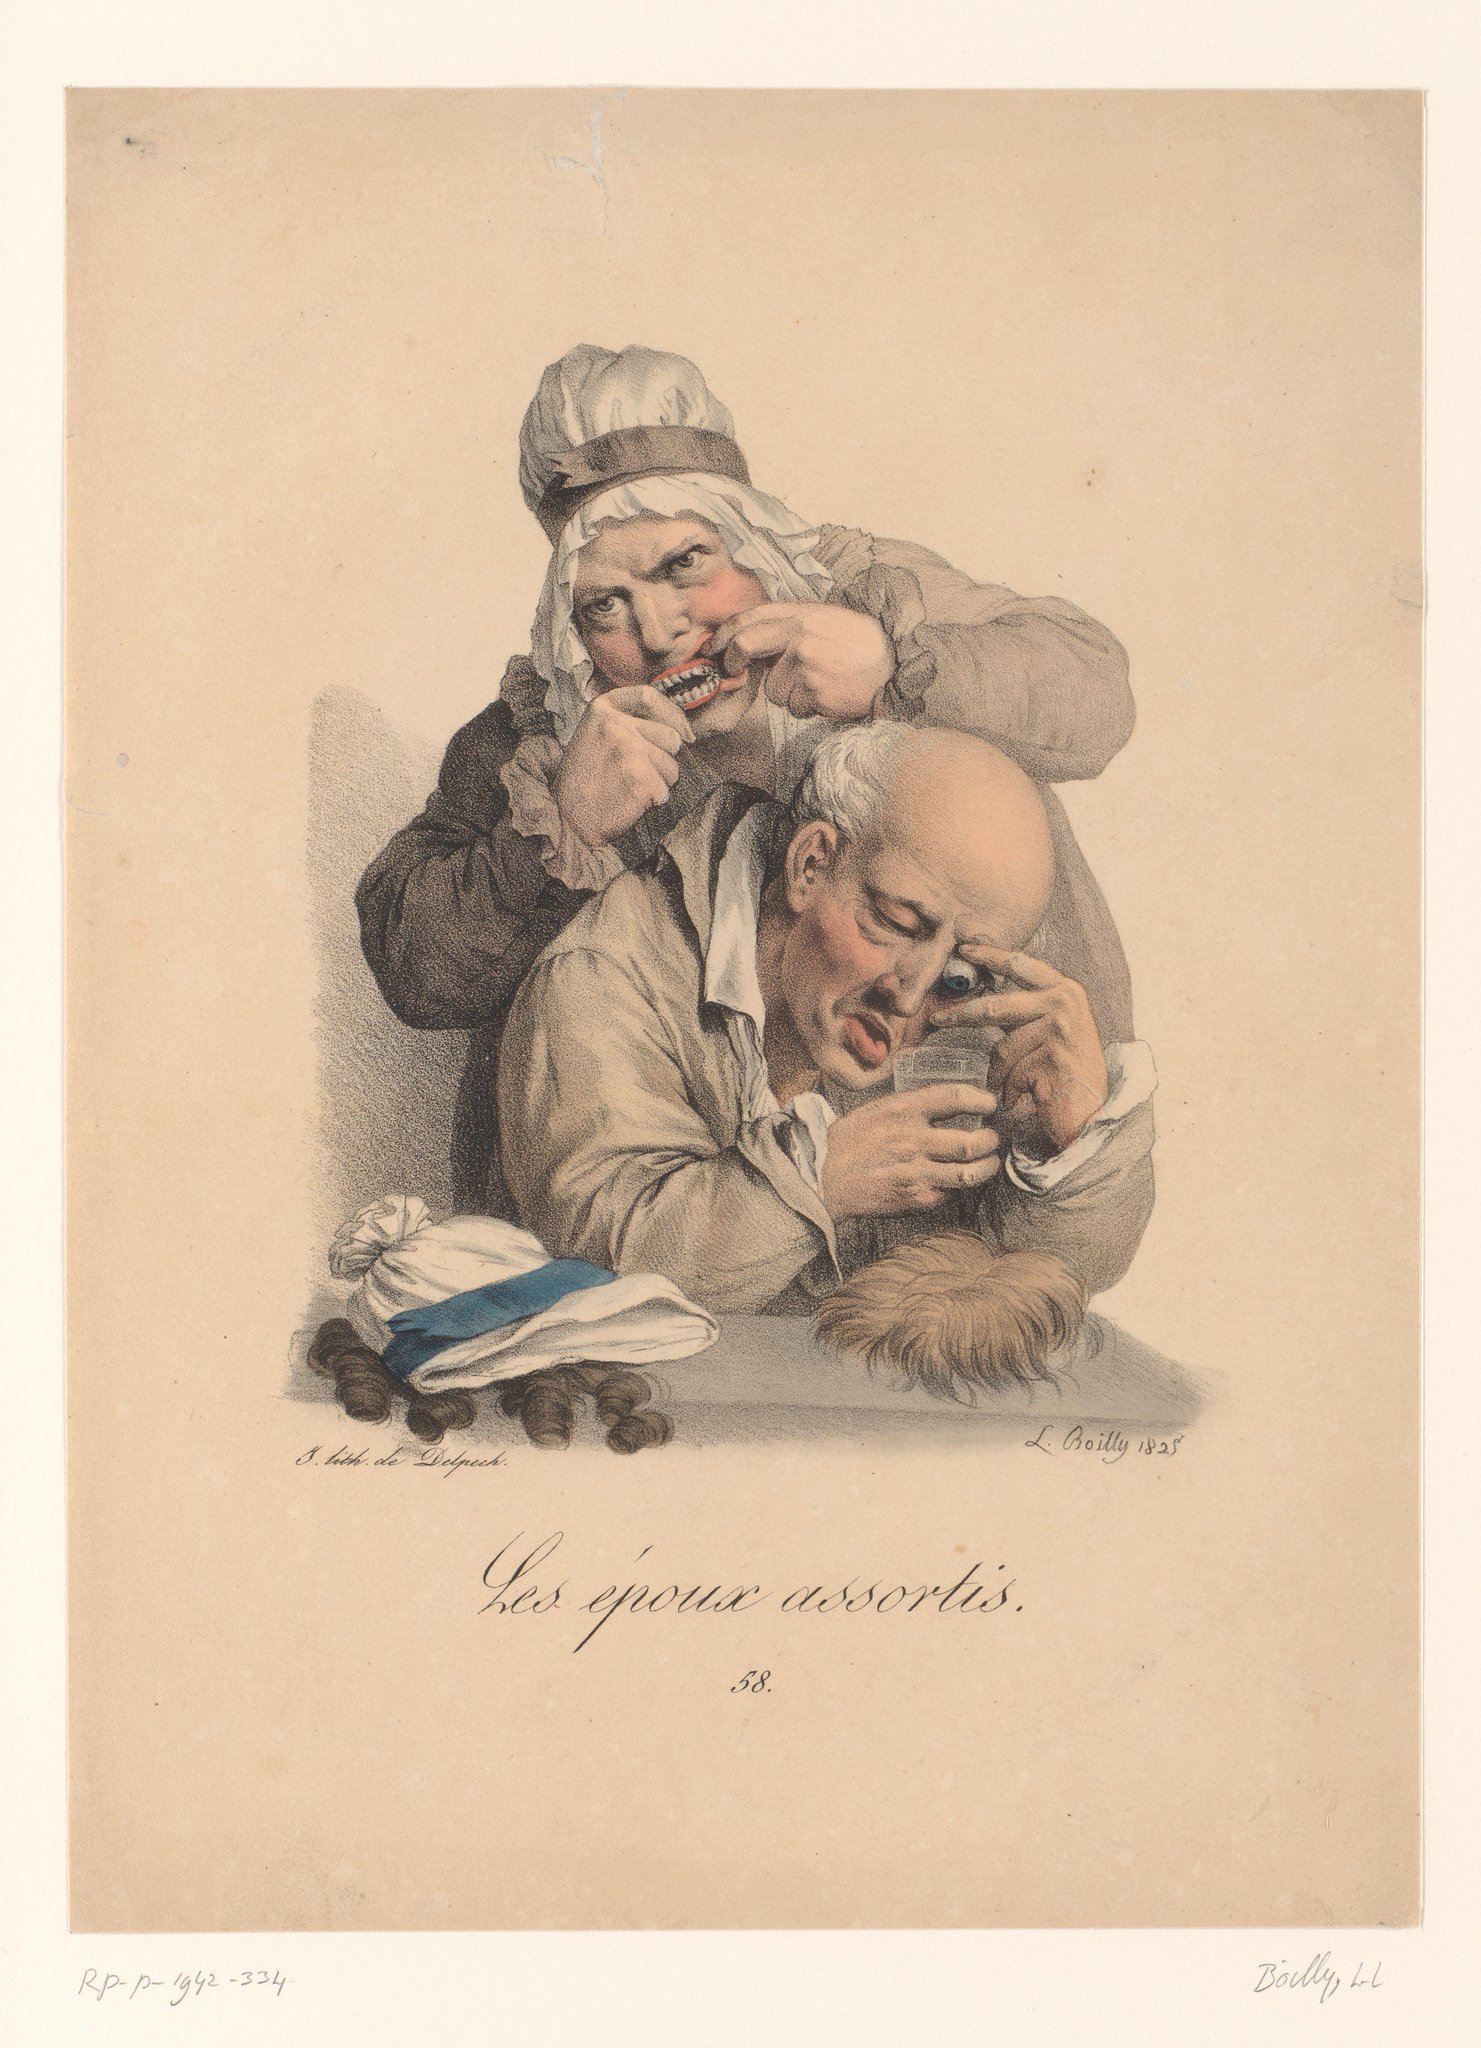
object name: cartoon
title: Gezichten met een grimas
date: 1825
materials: paper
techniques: hand coloring, lithograph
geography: paris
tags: caricatures (human types), teeth - aa - female human figure, eyes, satire on marriage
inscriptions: collector's mark: Lugt 2760, collector's mark: Lugt 2228a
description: De echtelieden passen bij elkaar (époux assortis) vanwege hun attributen.